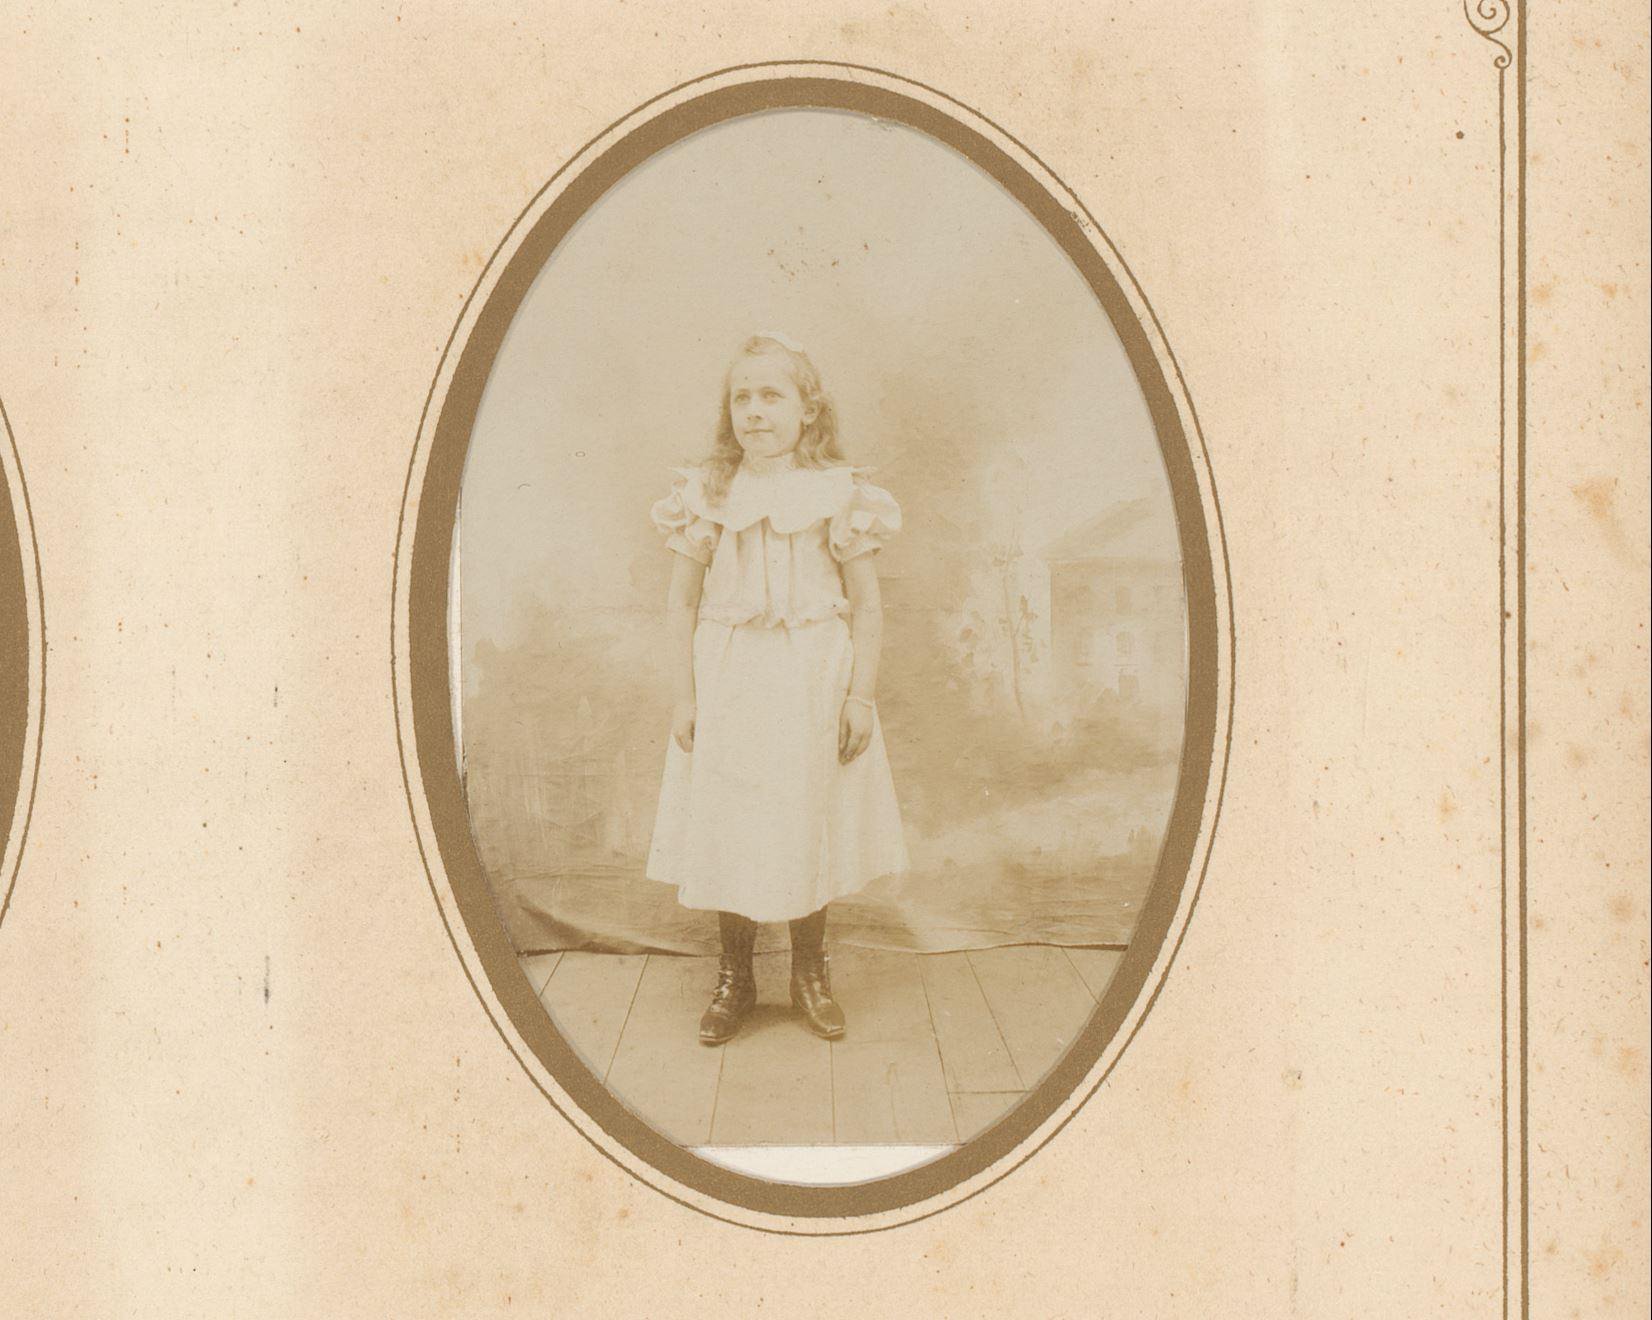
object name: photograph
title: Portret van een meisje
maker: Anonymous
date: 1880-1920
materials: cardboard, photographic support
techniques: collodion silver print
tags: historical persons, girl (child between toddler and youth)